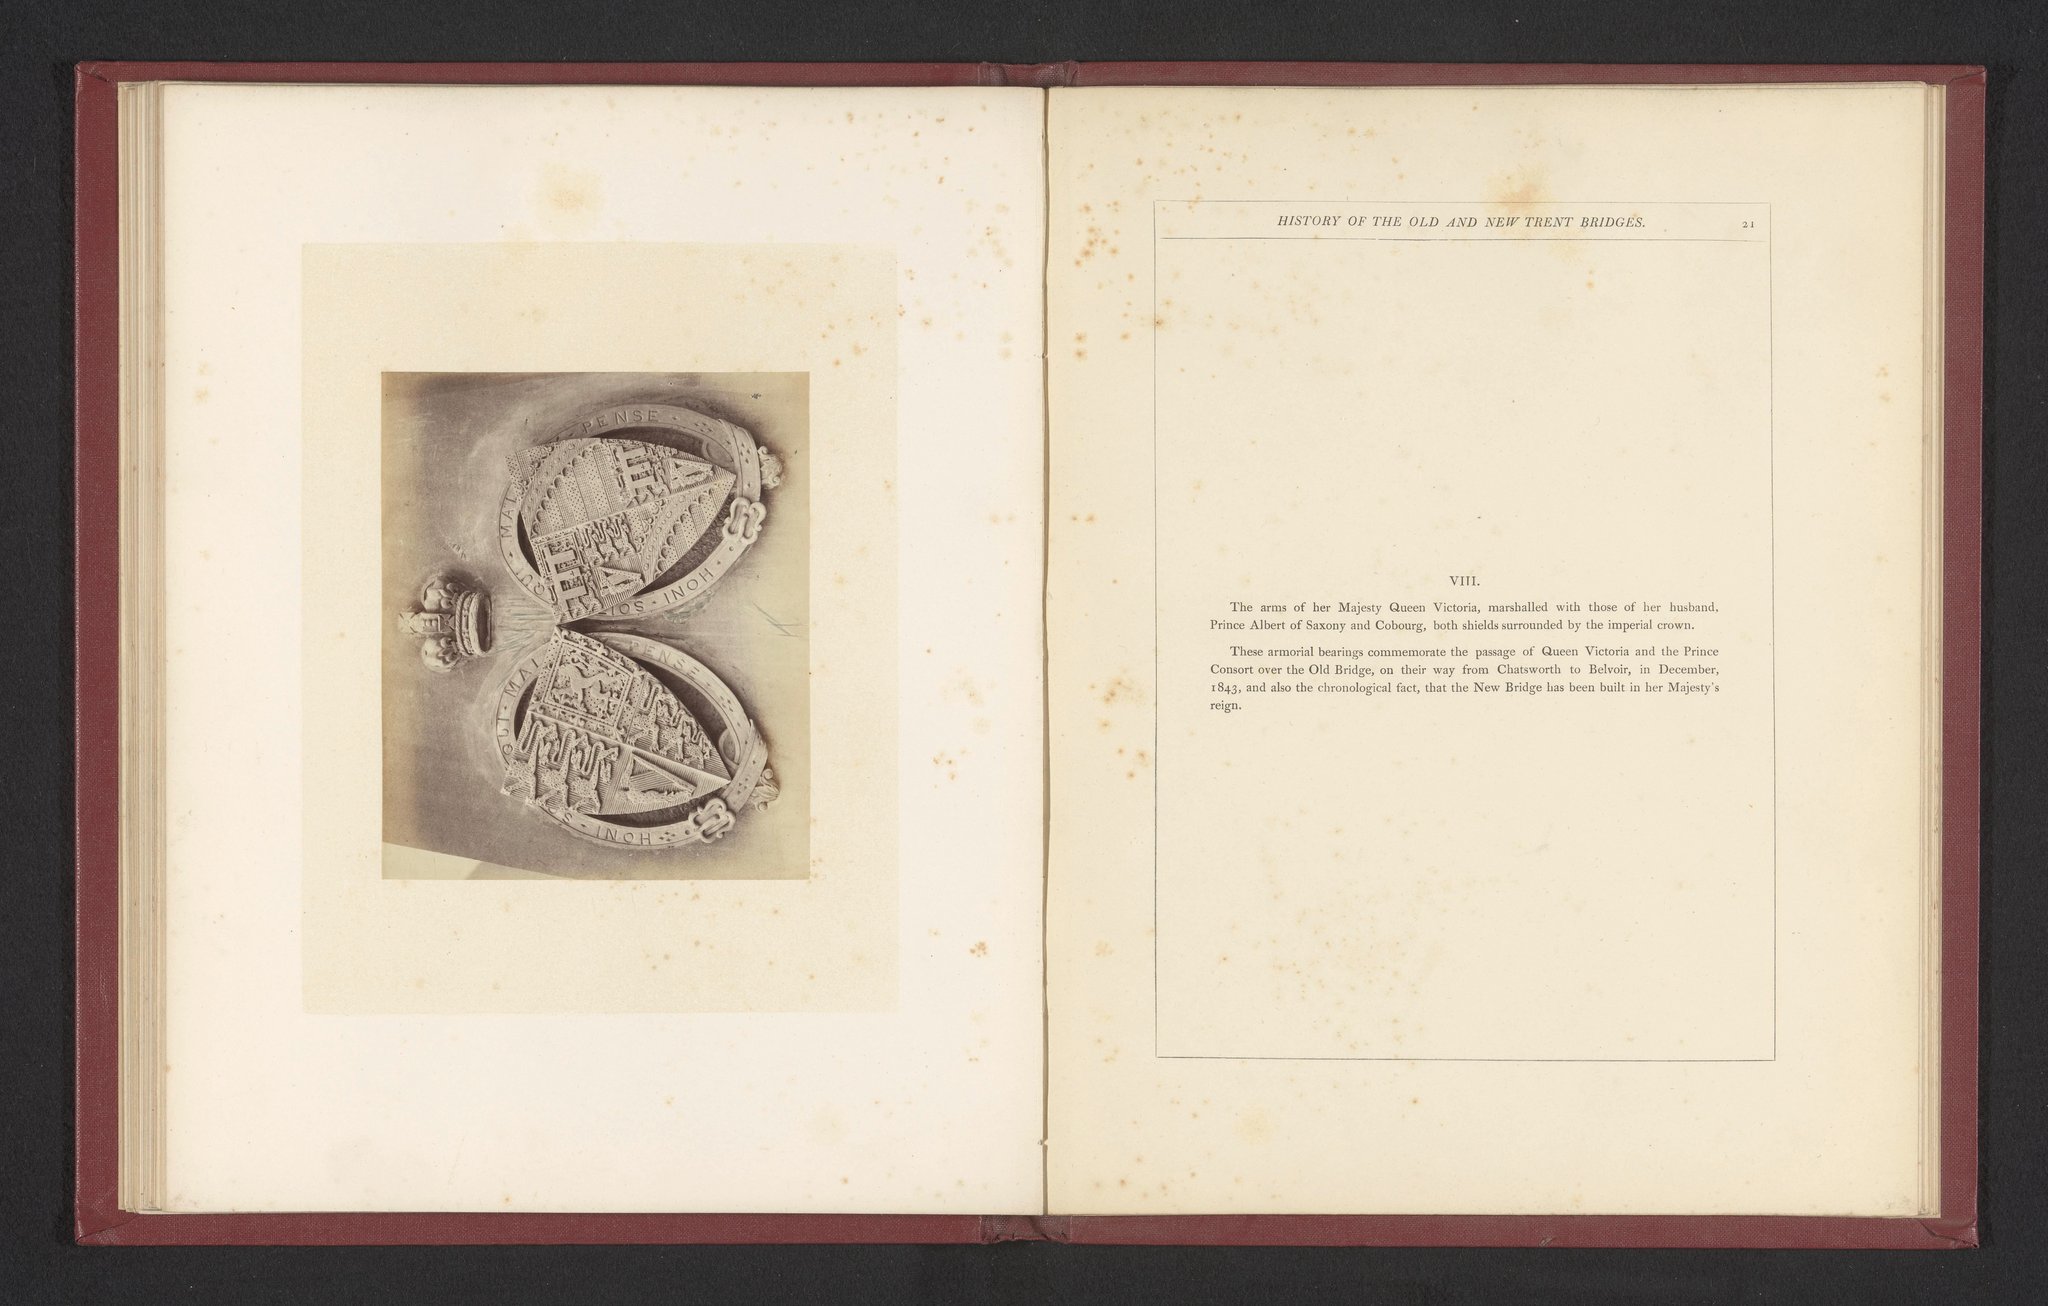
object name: page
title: Wapenschilden met de tekens van Victoria van het Verenigd Koninkrijk en Albert van Saksen-Coburg en Gotha op de Trent Bridge in Nottingham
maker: Anonymous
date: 1871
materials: photographic support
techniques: albumen print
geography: nottingham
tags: victoria (koningin van het verenigd koninkrijk en keizerin van india), albert (prins van saksen-coburg en gotha), coat of arms (as symbol of the state, etc.), bridge in city across river, canal, etc.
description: Boven een kroon, onder twee wapenschilden met leeuwen en brugpijlers.